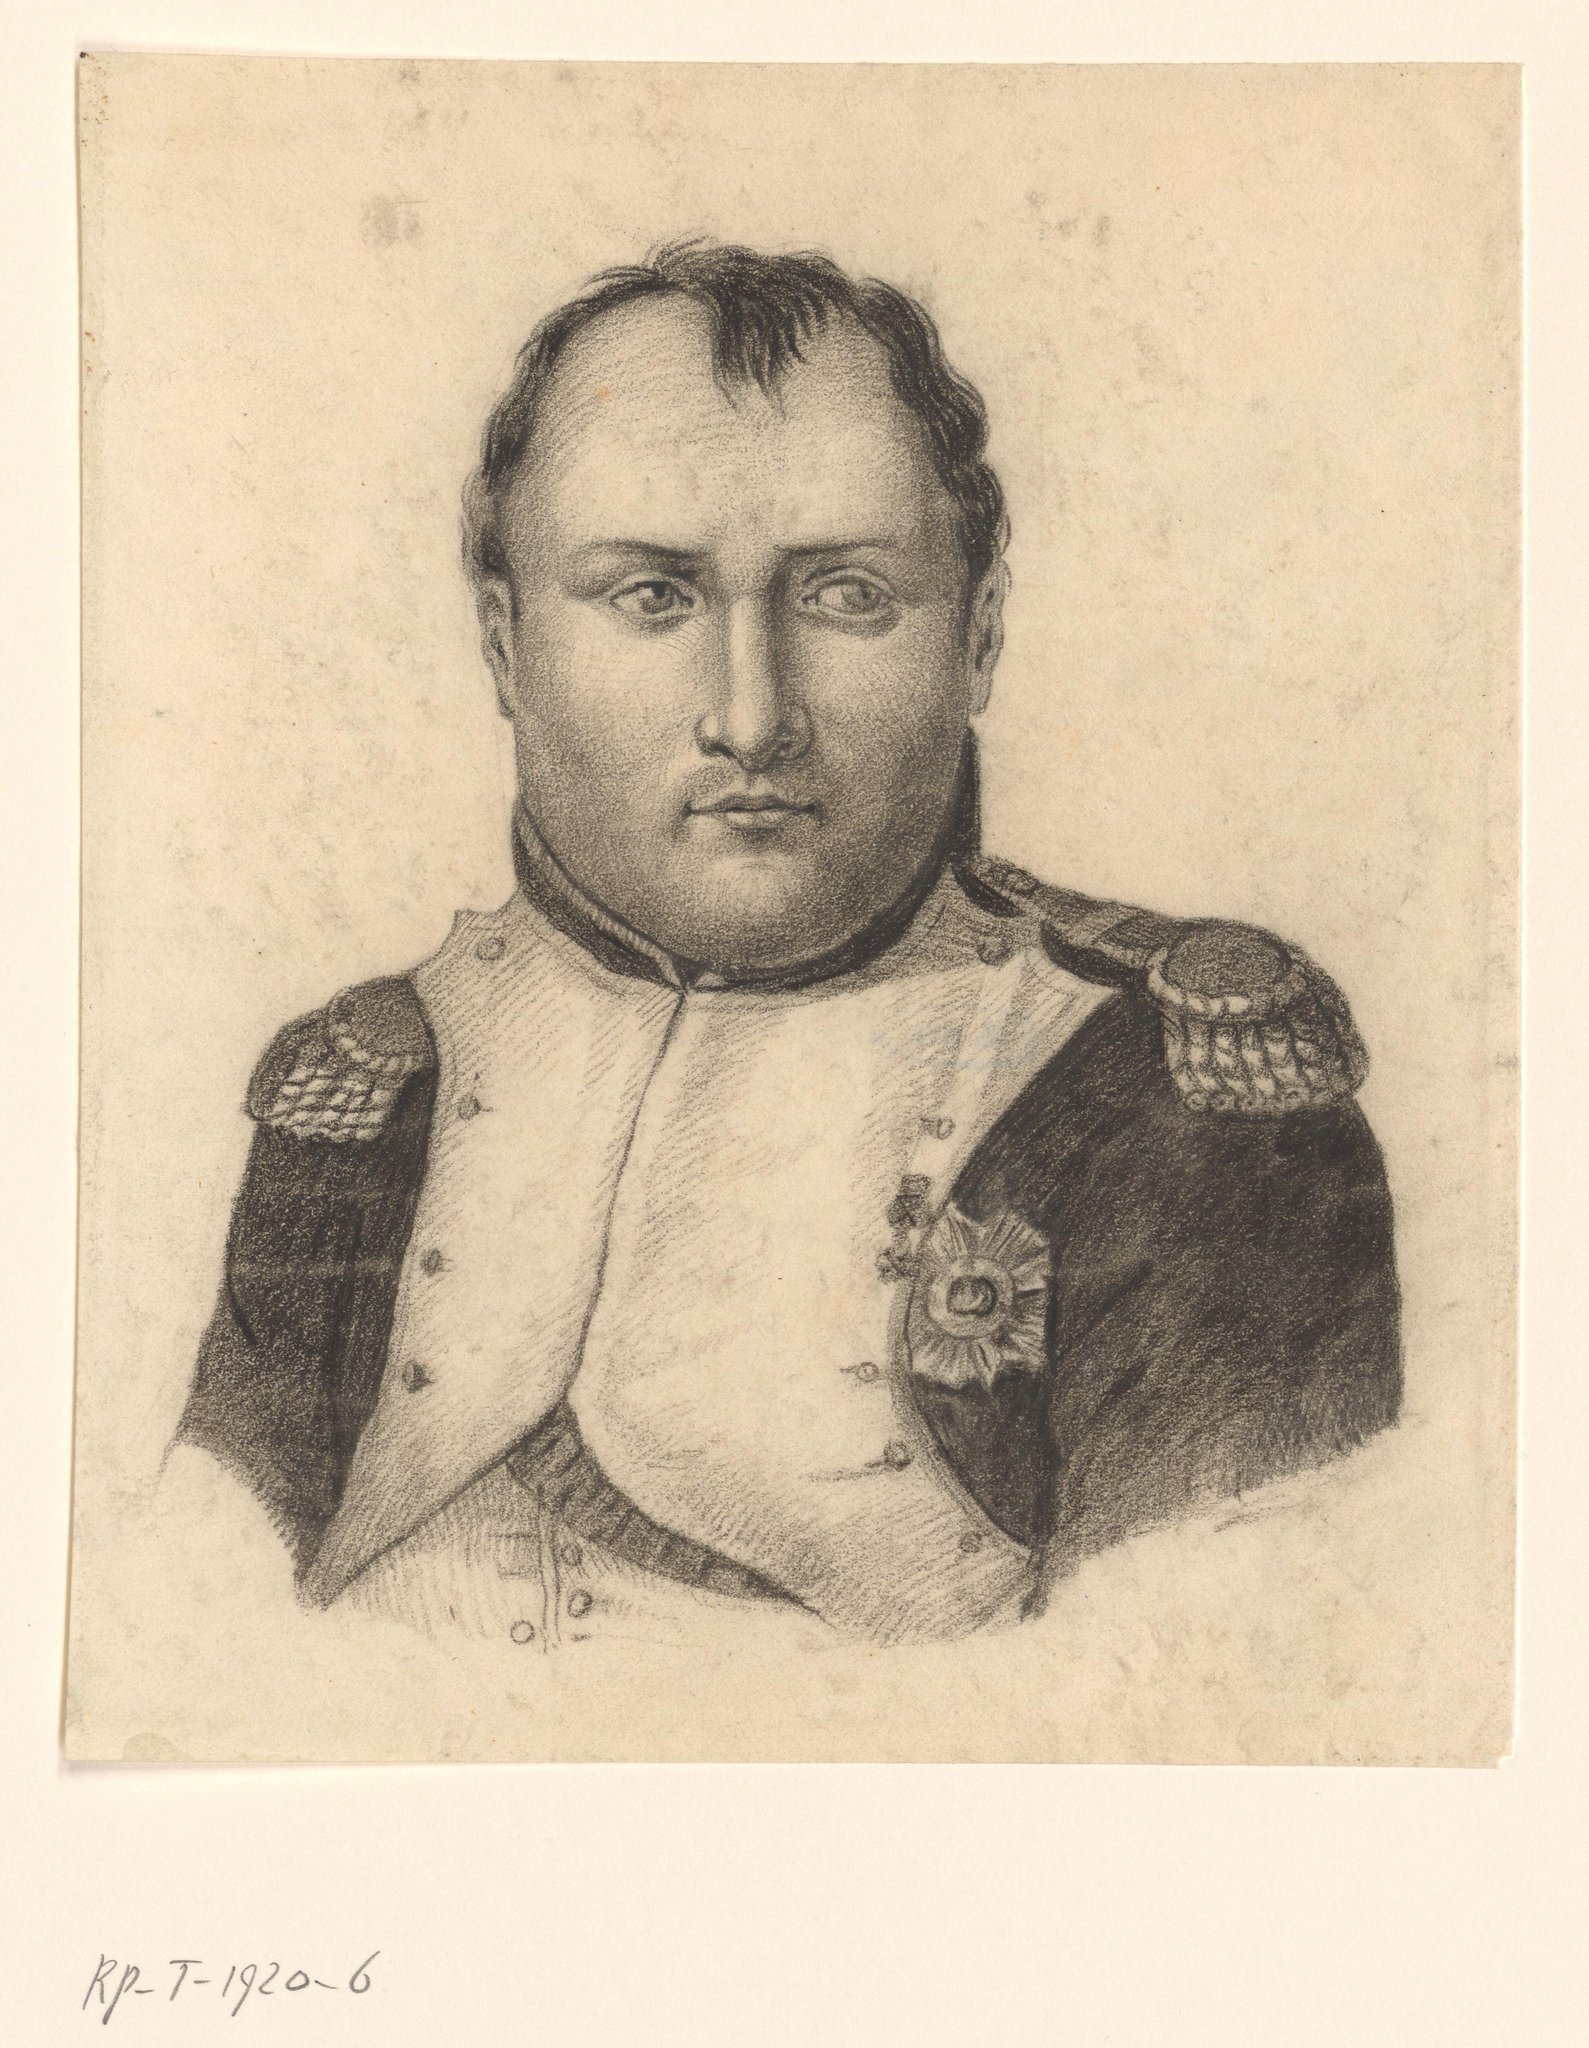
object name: drawing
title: Portret van Napoleon I Bonaparte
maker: Anonymous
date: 1804-1899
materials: chalk, paper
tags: napoleon i (emperor of the french), historical persons, emperor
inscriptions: collector's mark: Lugt 2228